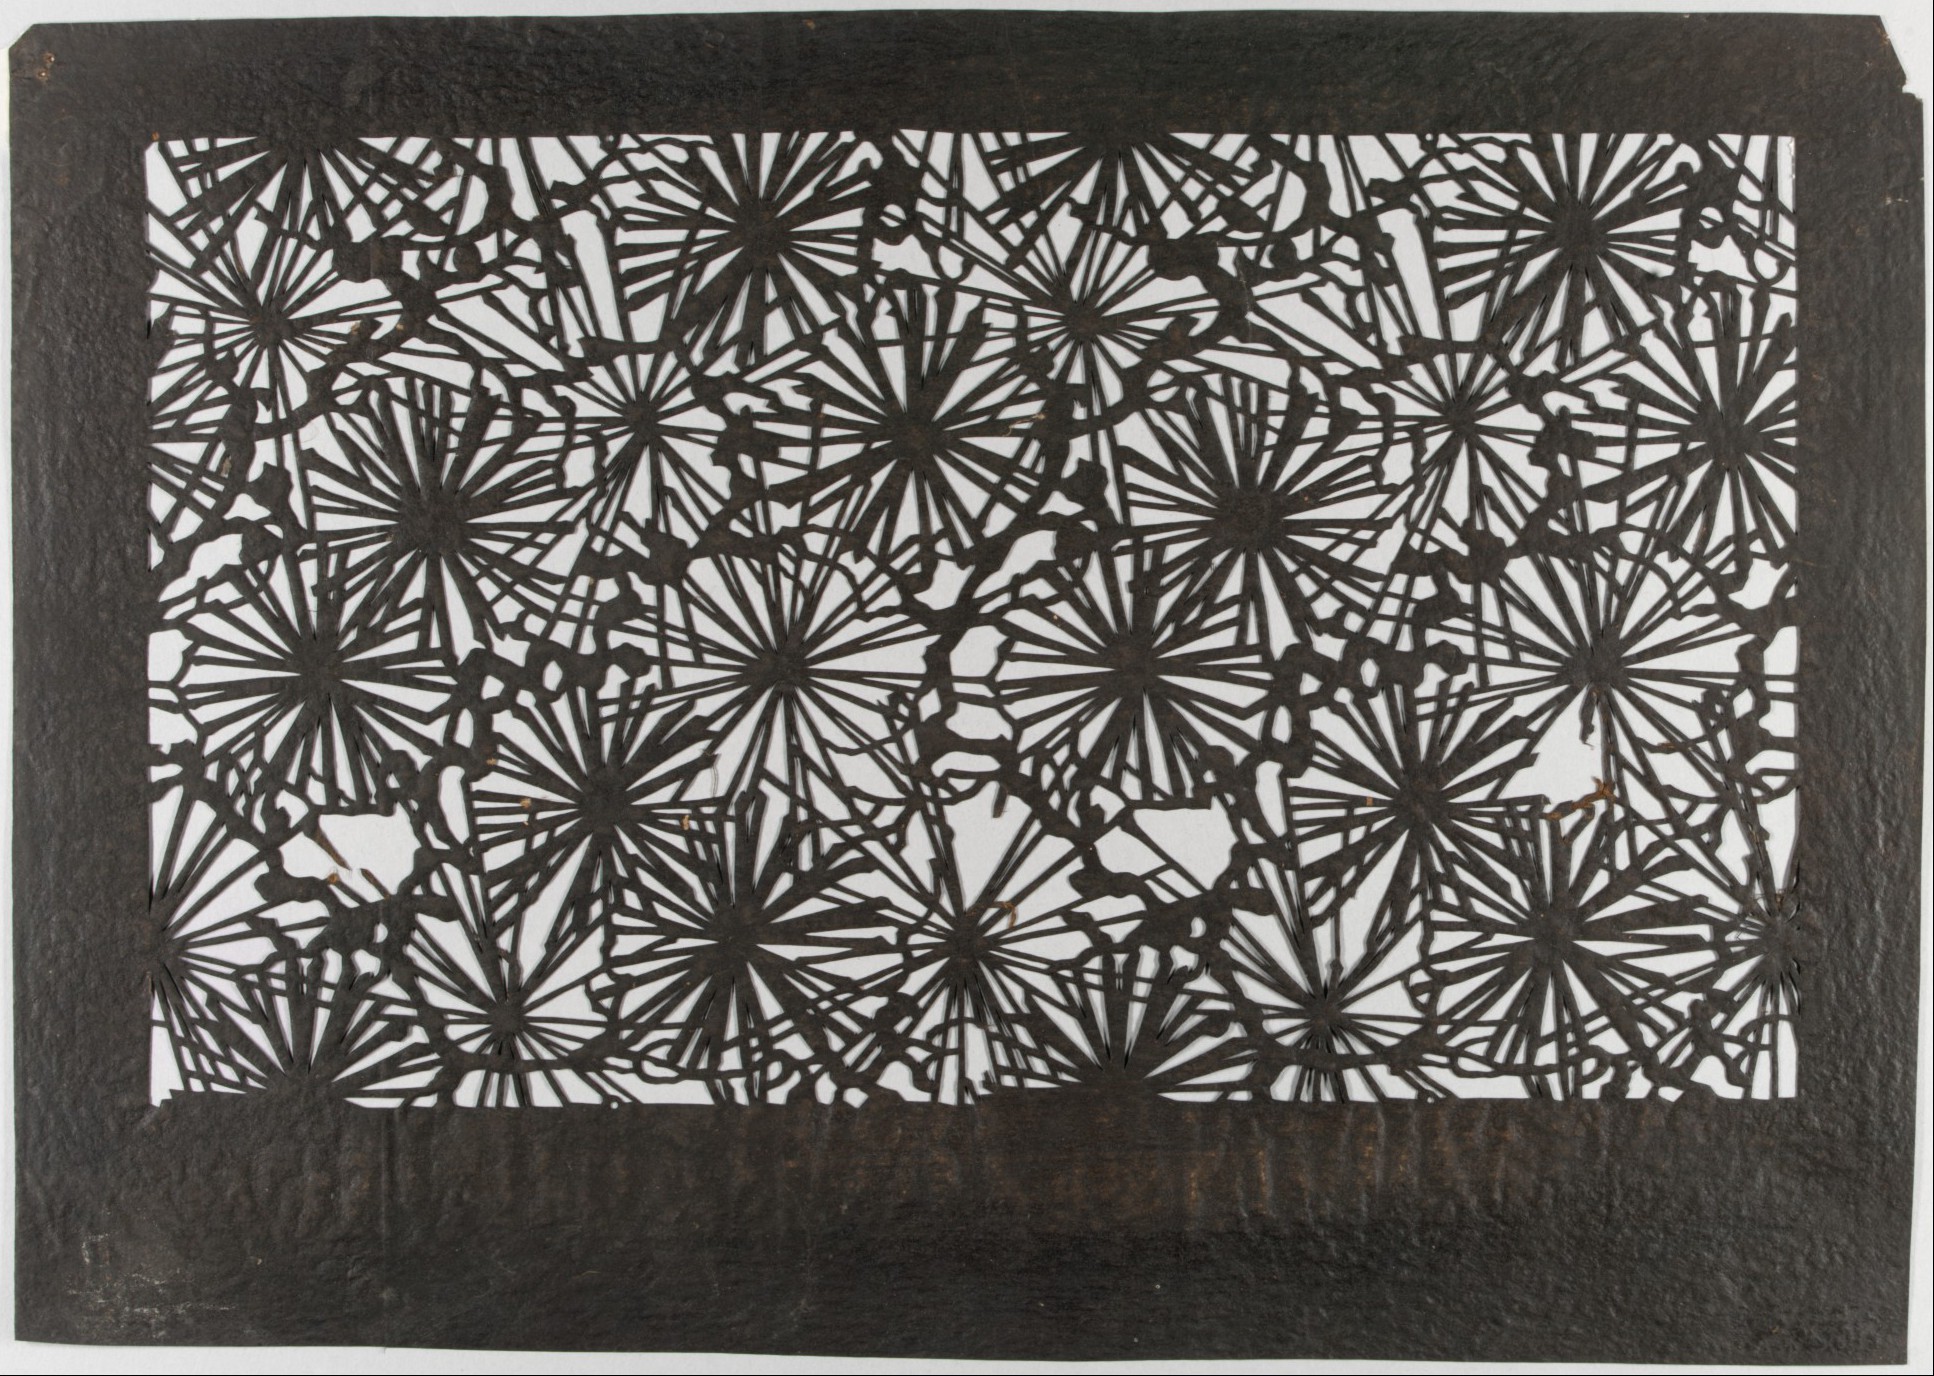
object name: stencil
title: Stencil with Pine Branches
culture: japanese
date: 1801-1900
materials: paper